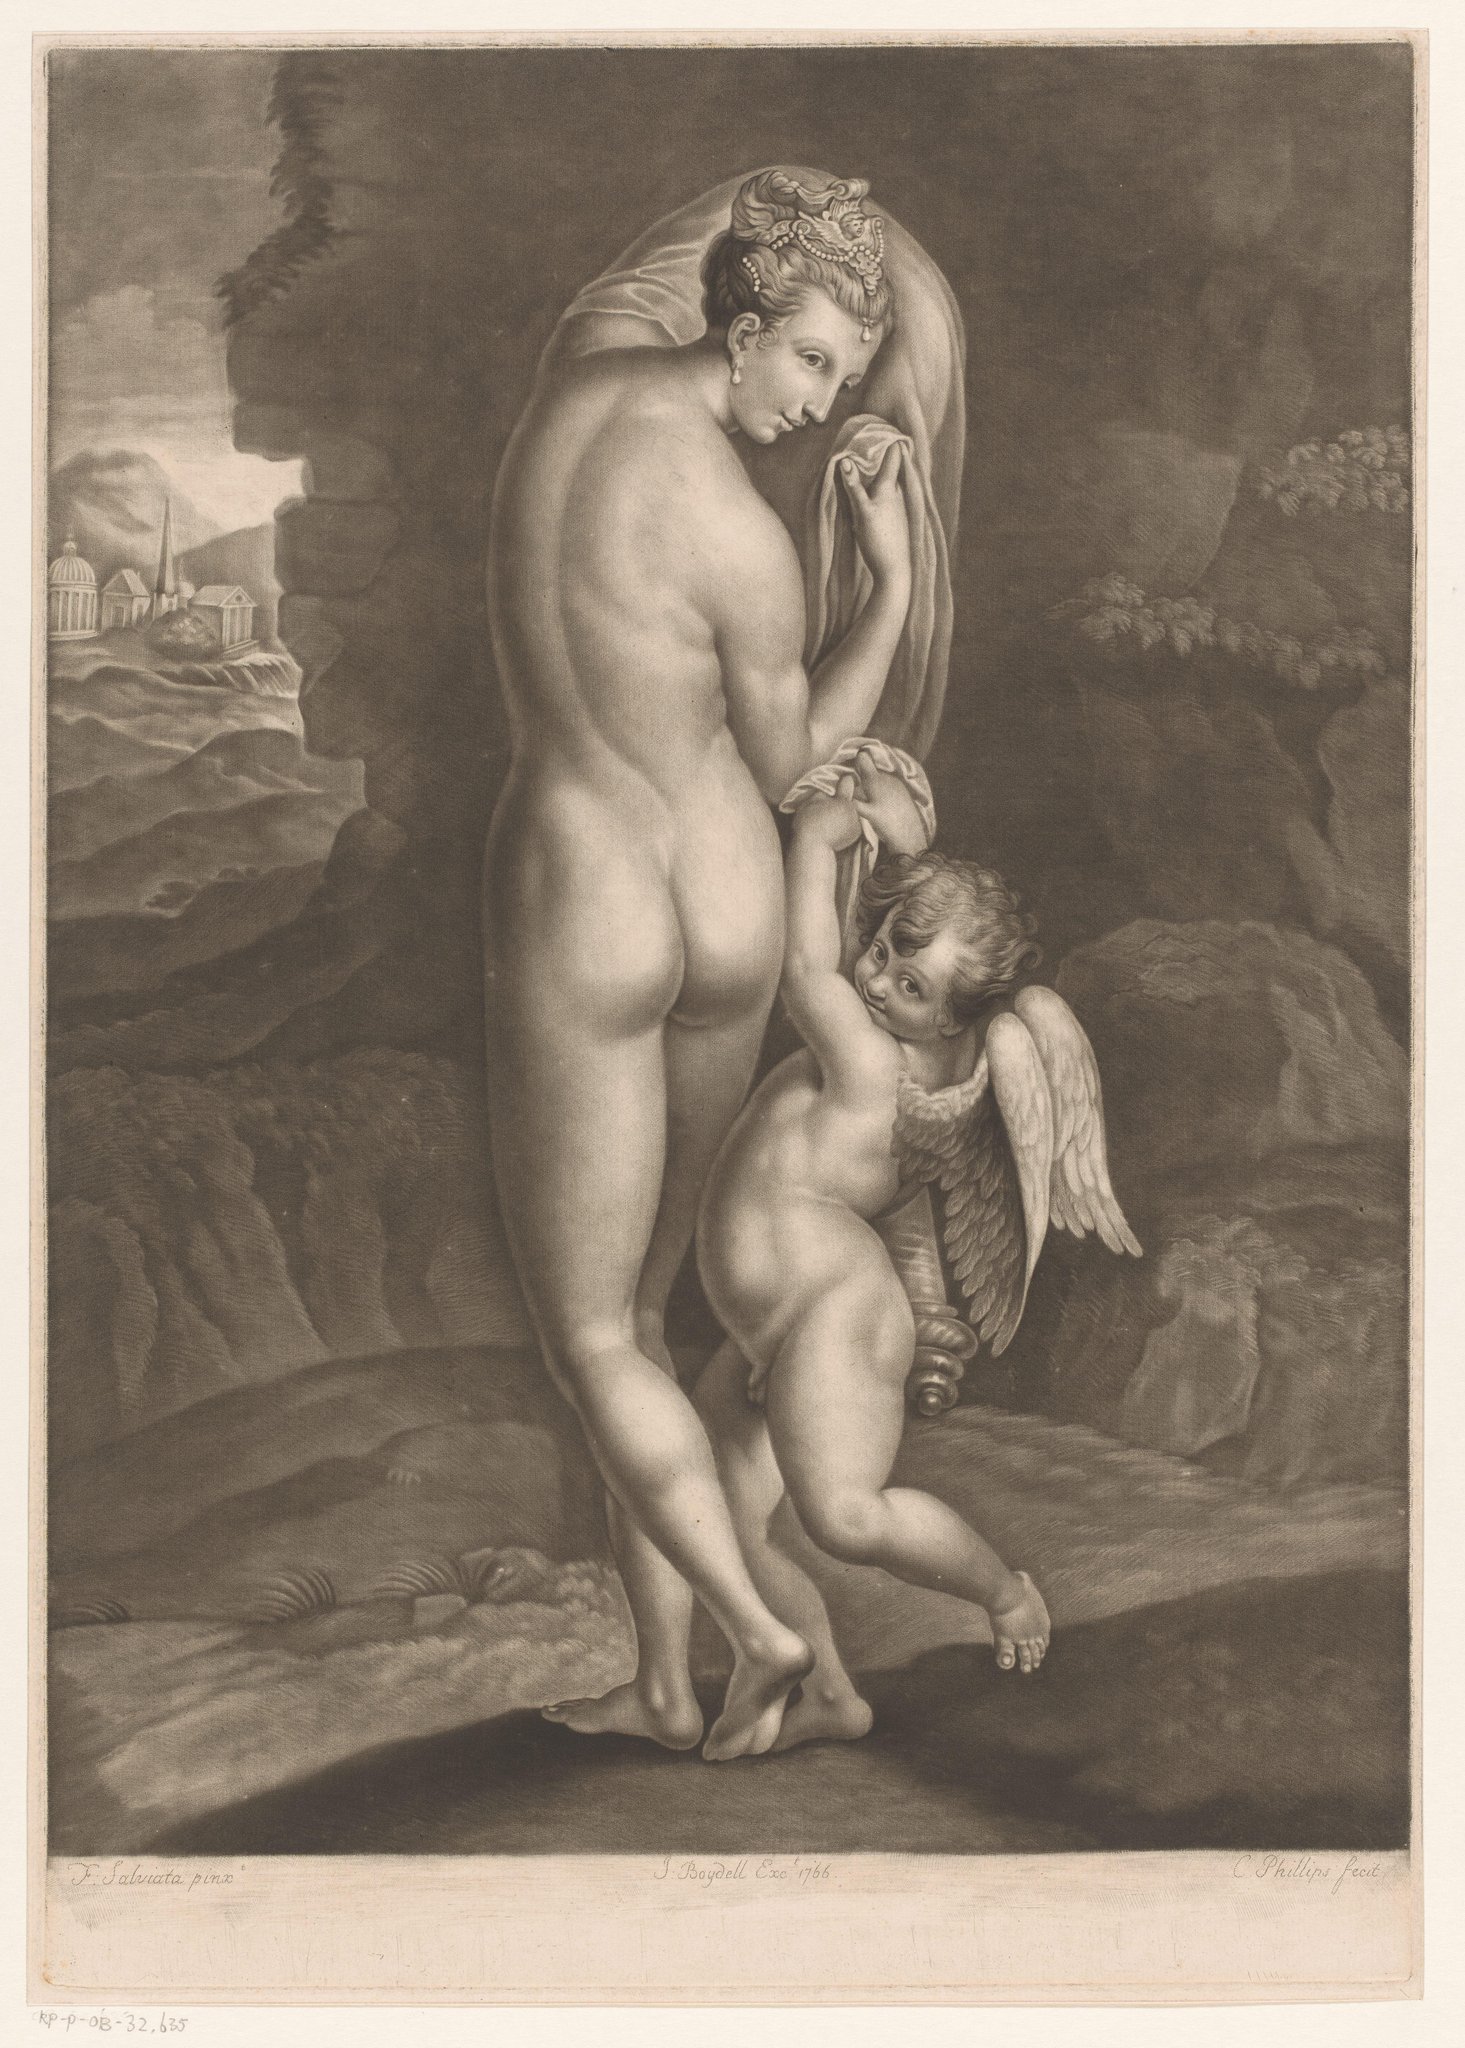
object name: print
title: Venus en Cupido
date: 1766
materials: paper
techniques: mezzotint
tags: venus and cupid (cupid not being mere attribute)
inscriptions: collector's mark: Lugt 240